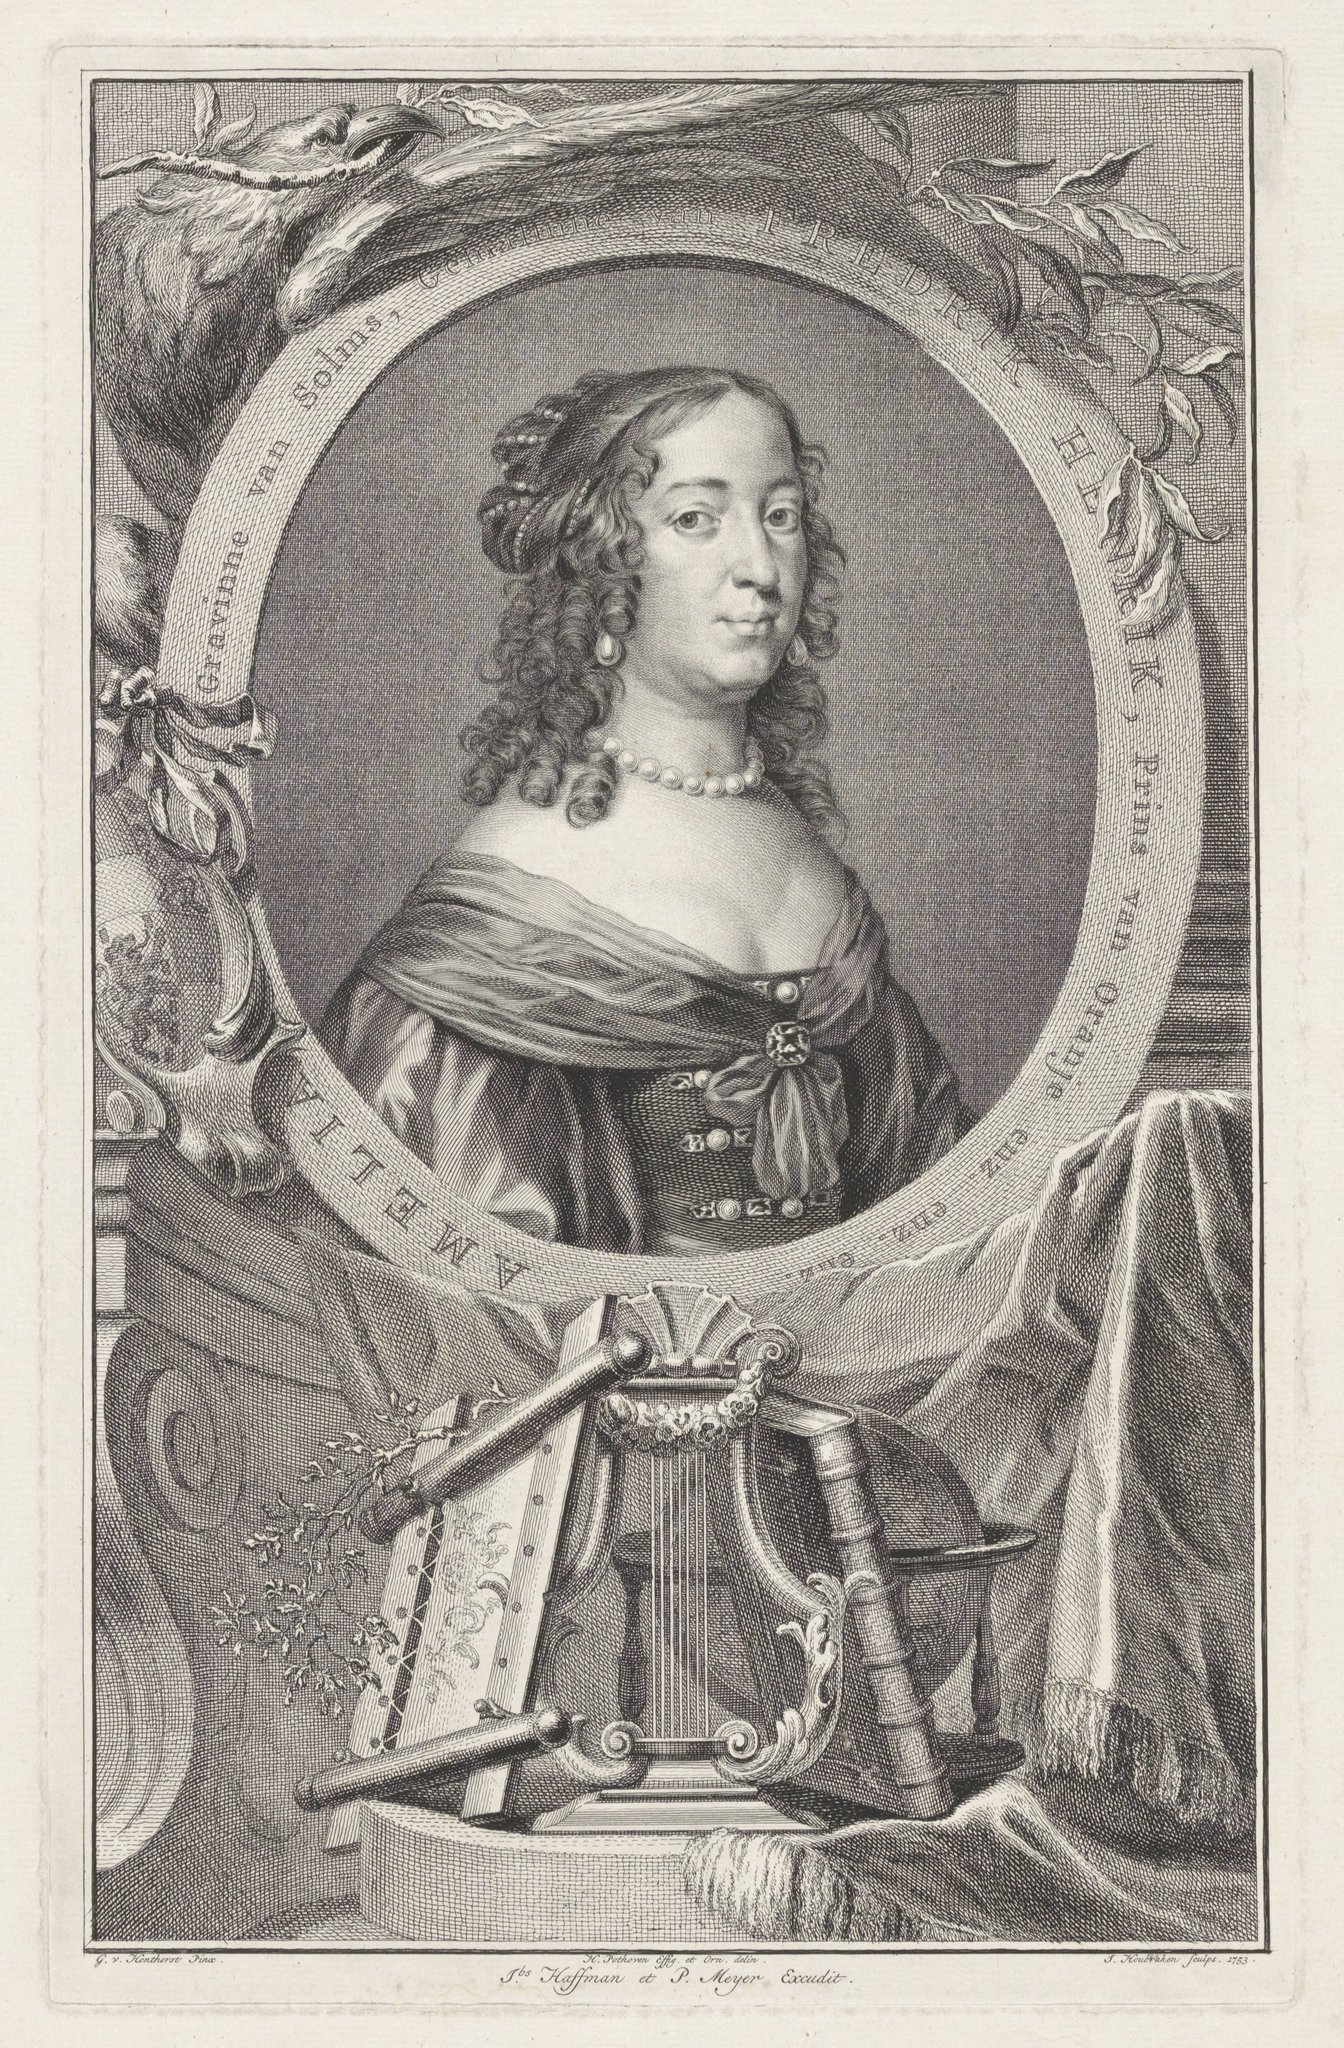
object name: print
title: Portret van Amalia van Solms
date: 1753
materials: paper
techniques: engraving, etching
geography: amsterdam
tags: the hague, amalia of solms-braunfels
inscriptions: date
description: Portret van Amalia in een ovaal met randschrift. Rondom ligt een aantal allegorische objecten.